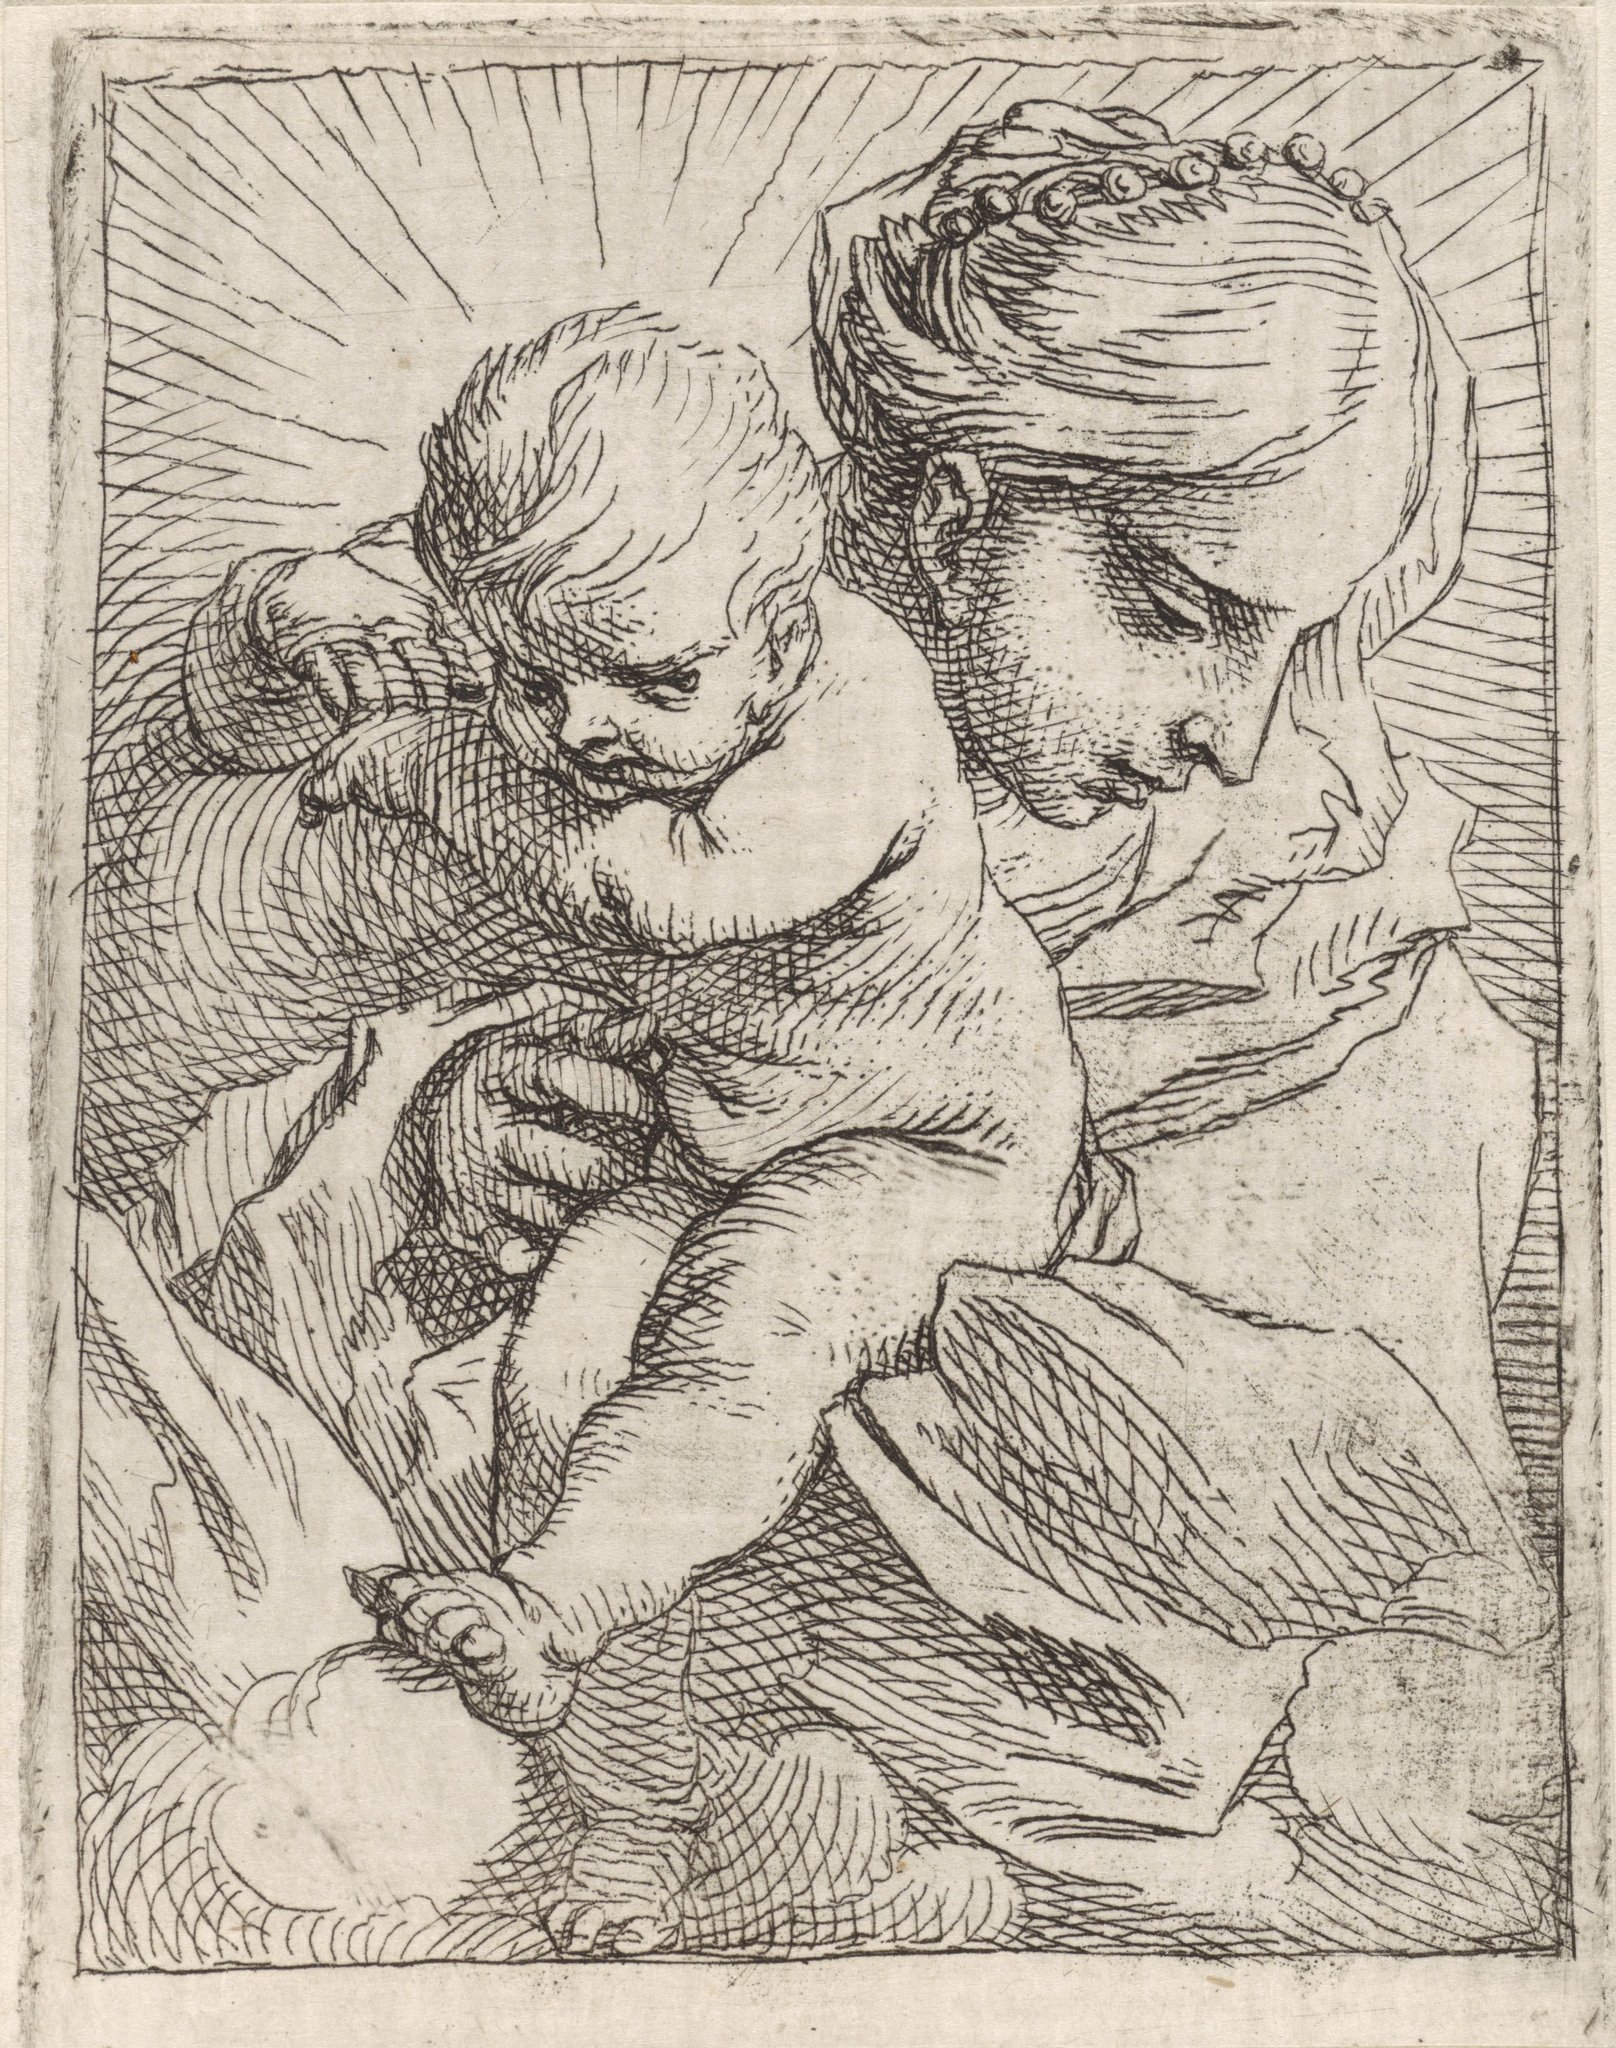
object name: print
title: Madonna met kind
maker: cornelis schut (i)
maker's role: draughtsman, print maker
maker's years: 1597-1655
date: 1618-1655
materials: paper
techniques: etching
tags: madonna: i.e. mary with the christ-child